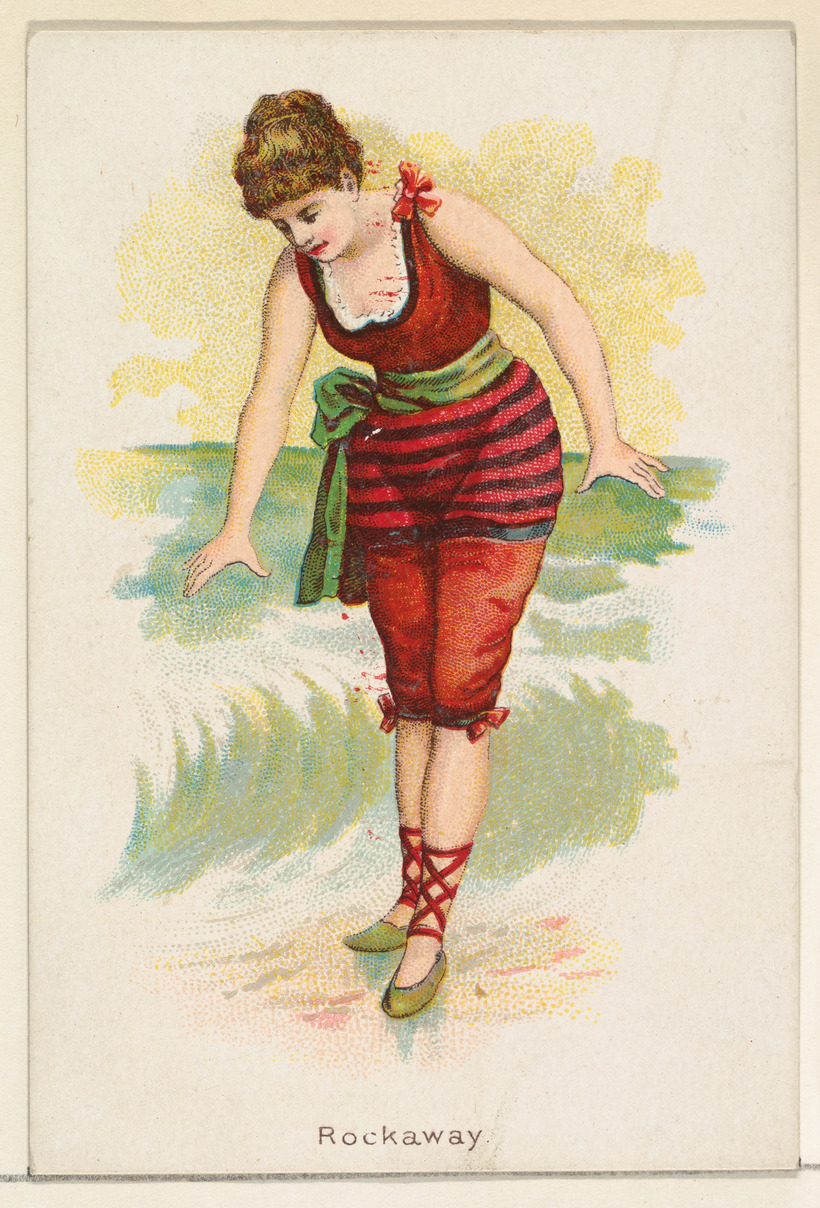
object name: print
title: Rockaway, from the Beautiful Bathers series (N192) issued by Wm. S. Kimball & Co.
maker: william s. kimball & company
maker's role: publisher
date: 1889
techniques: color lithograph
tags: women